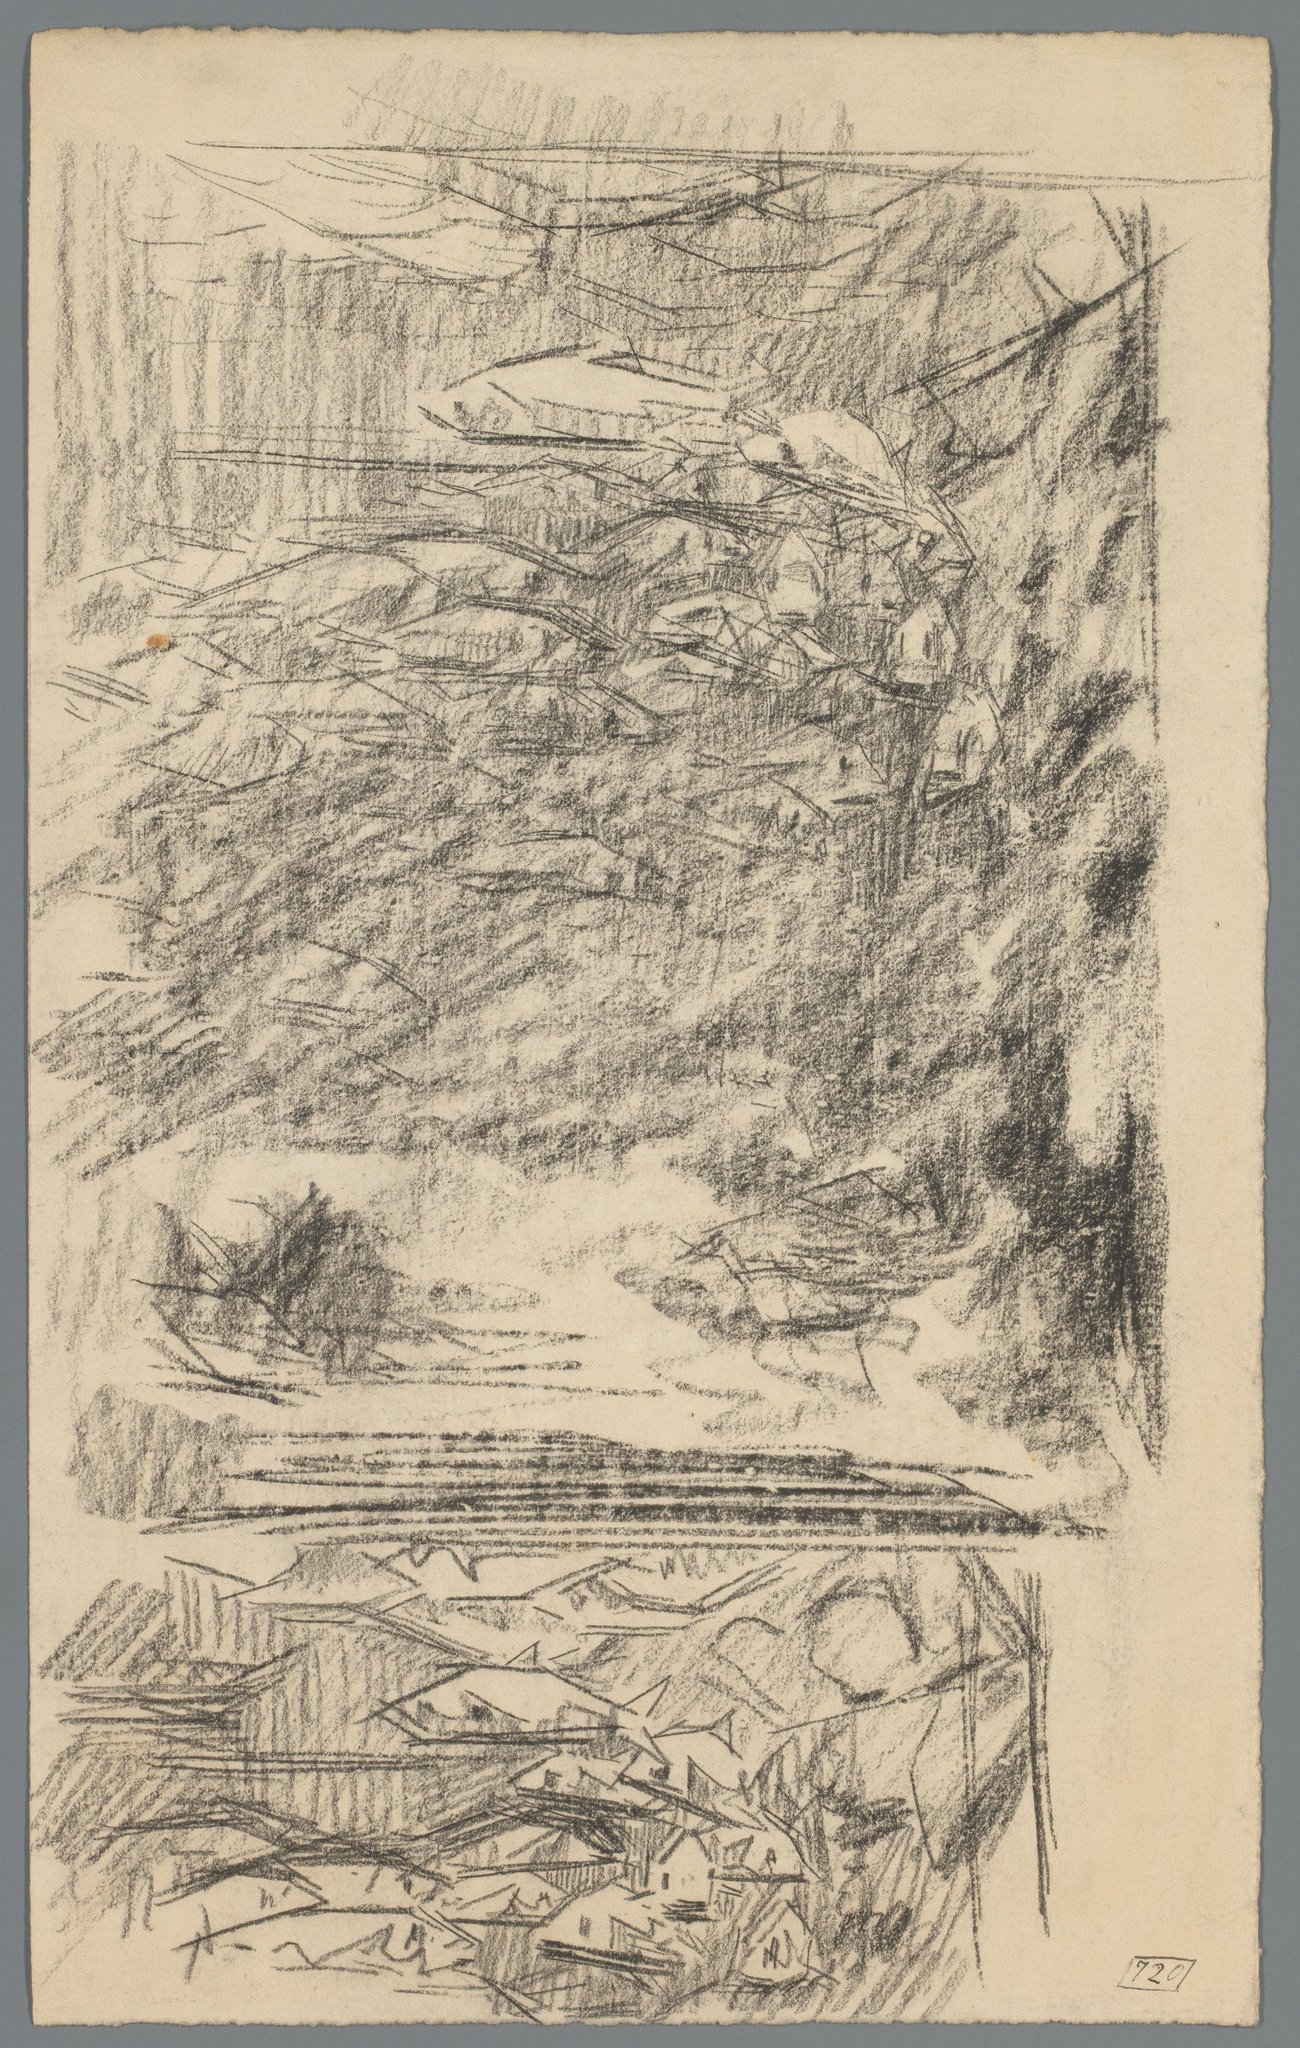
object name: drawing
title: Studie van een aquarium met vissen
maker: gerrit willem dijsselhof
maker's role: designer, draughtsman, print maker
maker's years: 1866-1924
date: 1876-1924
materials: chalk, paper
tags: aquarium, bony fishes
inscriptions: number: ‘720’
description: Met op verso een fragment van een schets.